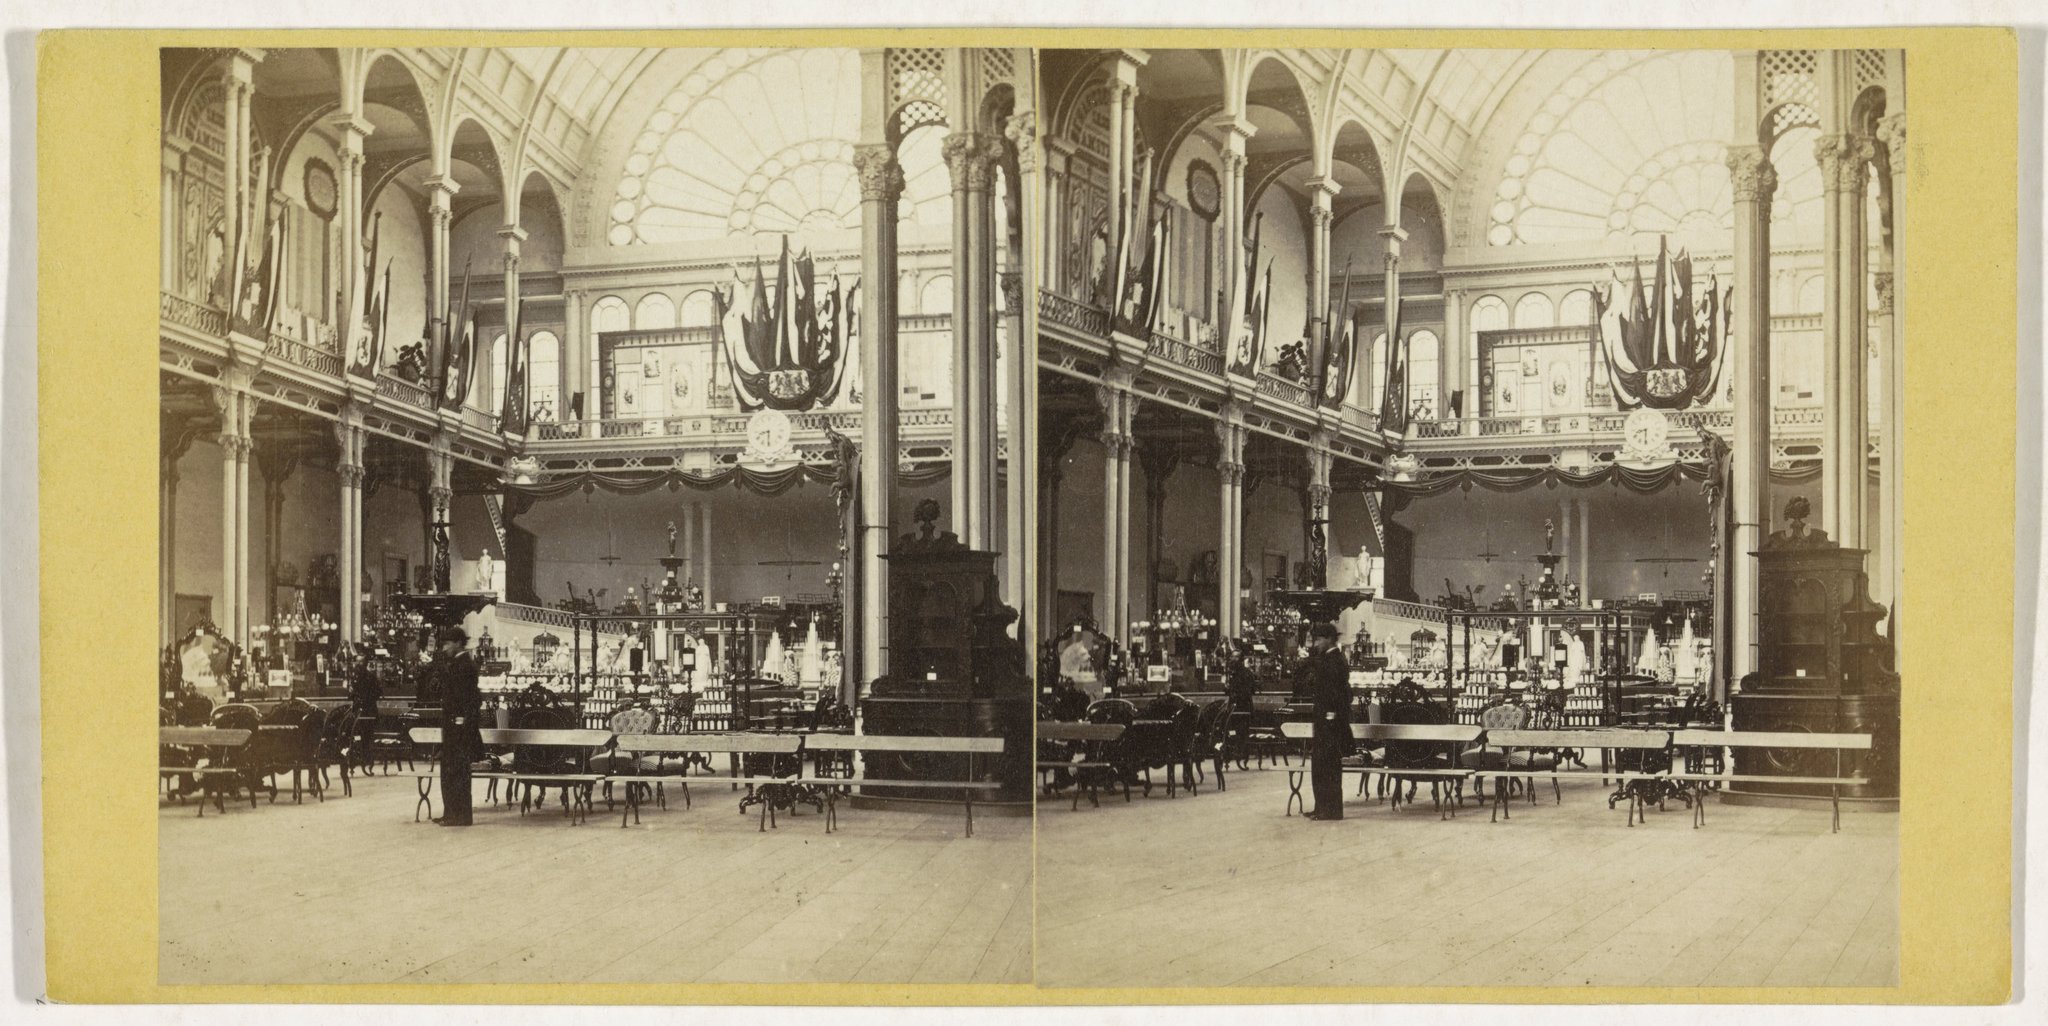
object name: stereograph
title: Zaal met uitgestalde objecten bij de Tentoonstelling voor Nationale Nijverheid in het Paleis voor Volksvlijt, Amsterdam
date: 1866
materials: cardboard, paper, photographic support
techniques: albumen print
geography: amsterdam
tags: paleis voor volksvlijt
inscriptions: label: ‘Boek & Kunsthandel Jan D. Brouwer, Kalverstraat E, Nº 37 Amsterdam.’, stamp: ‘JDB’